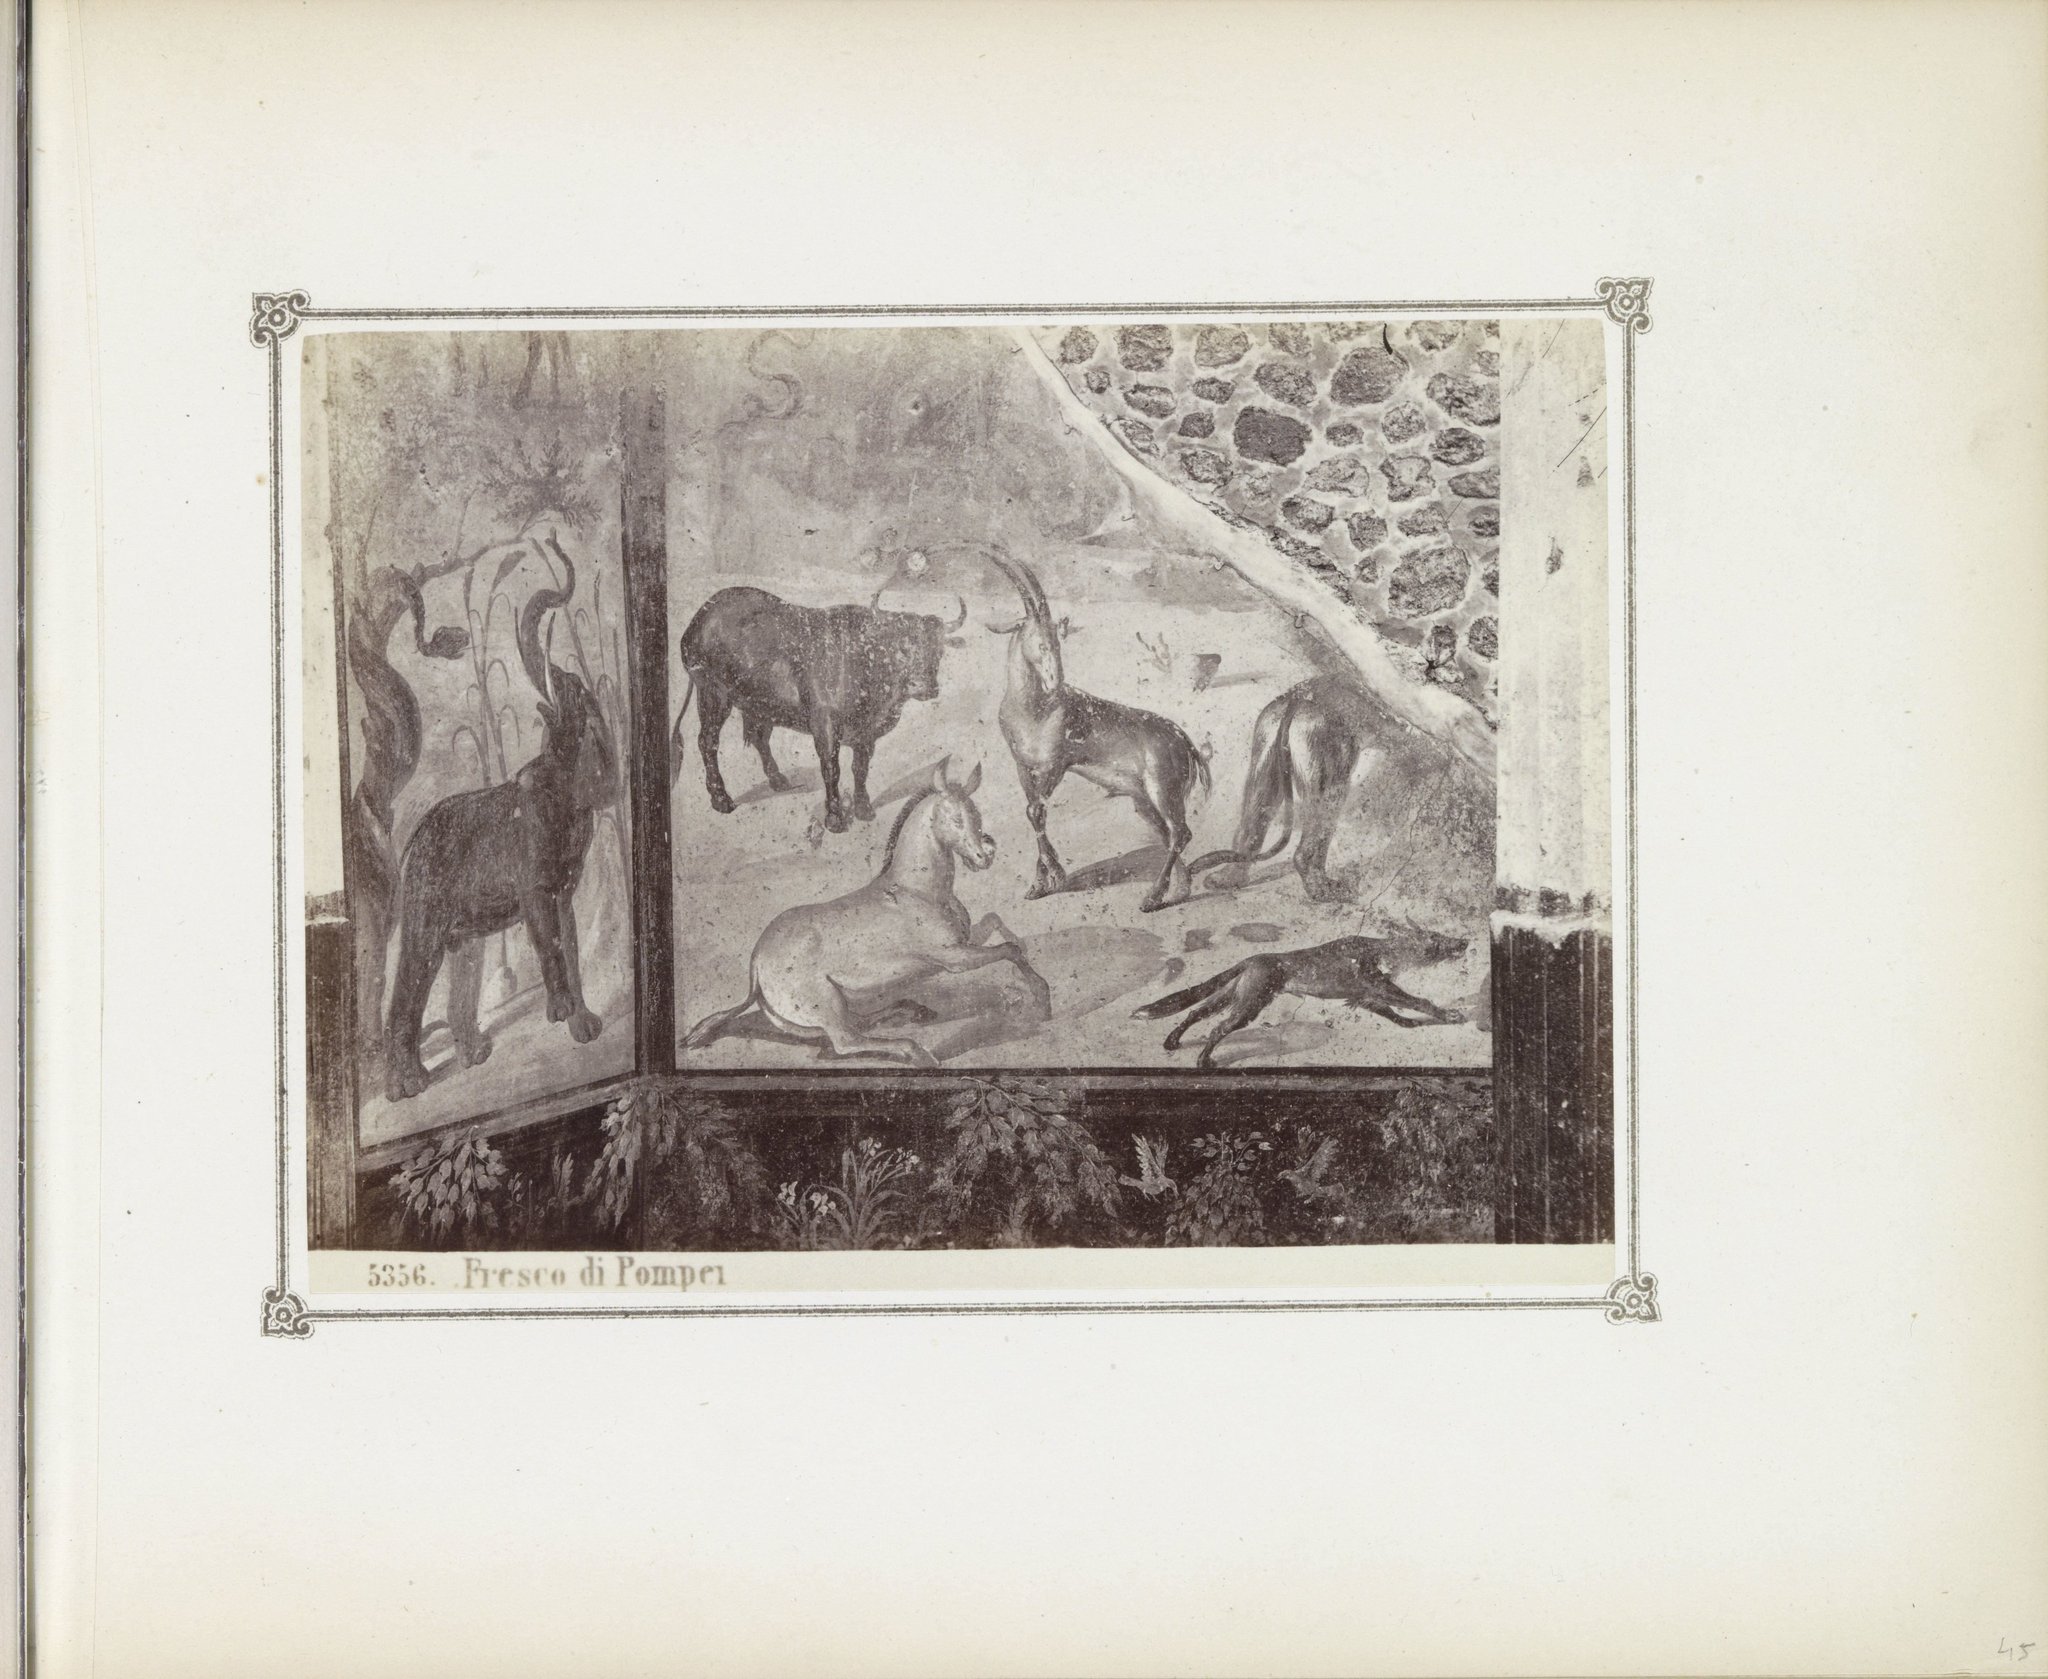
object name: album leaf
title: Fresco di Pompei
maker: giorgio sommer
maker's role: fotograaf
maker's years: 1834-1914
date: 1860-1900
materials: paper, photographic support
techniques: albumen print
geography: pompeii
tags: animals, painting (including book-illumination, miniature-painting) (+ plaster ~ arts), pompeii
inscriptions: number: ‘5356’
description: Onderdeel van Fotoalbum met opnames van opgravingen in Pompeï door Giorgio Sommer.